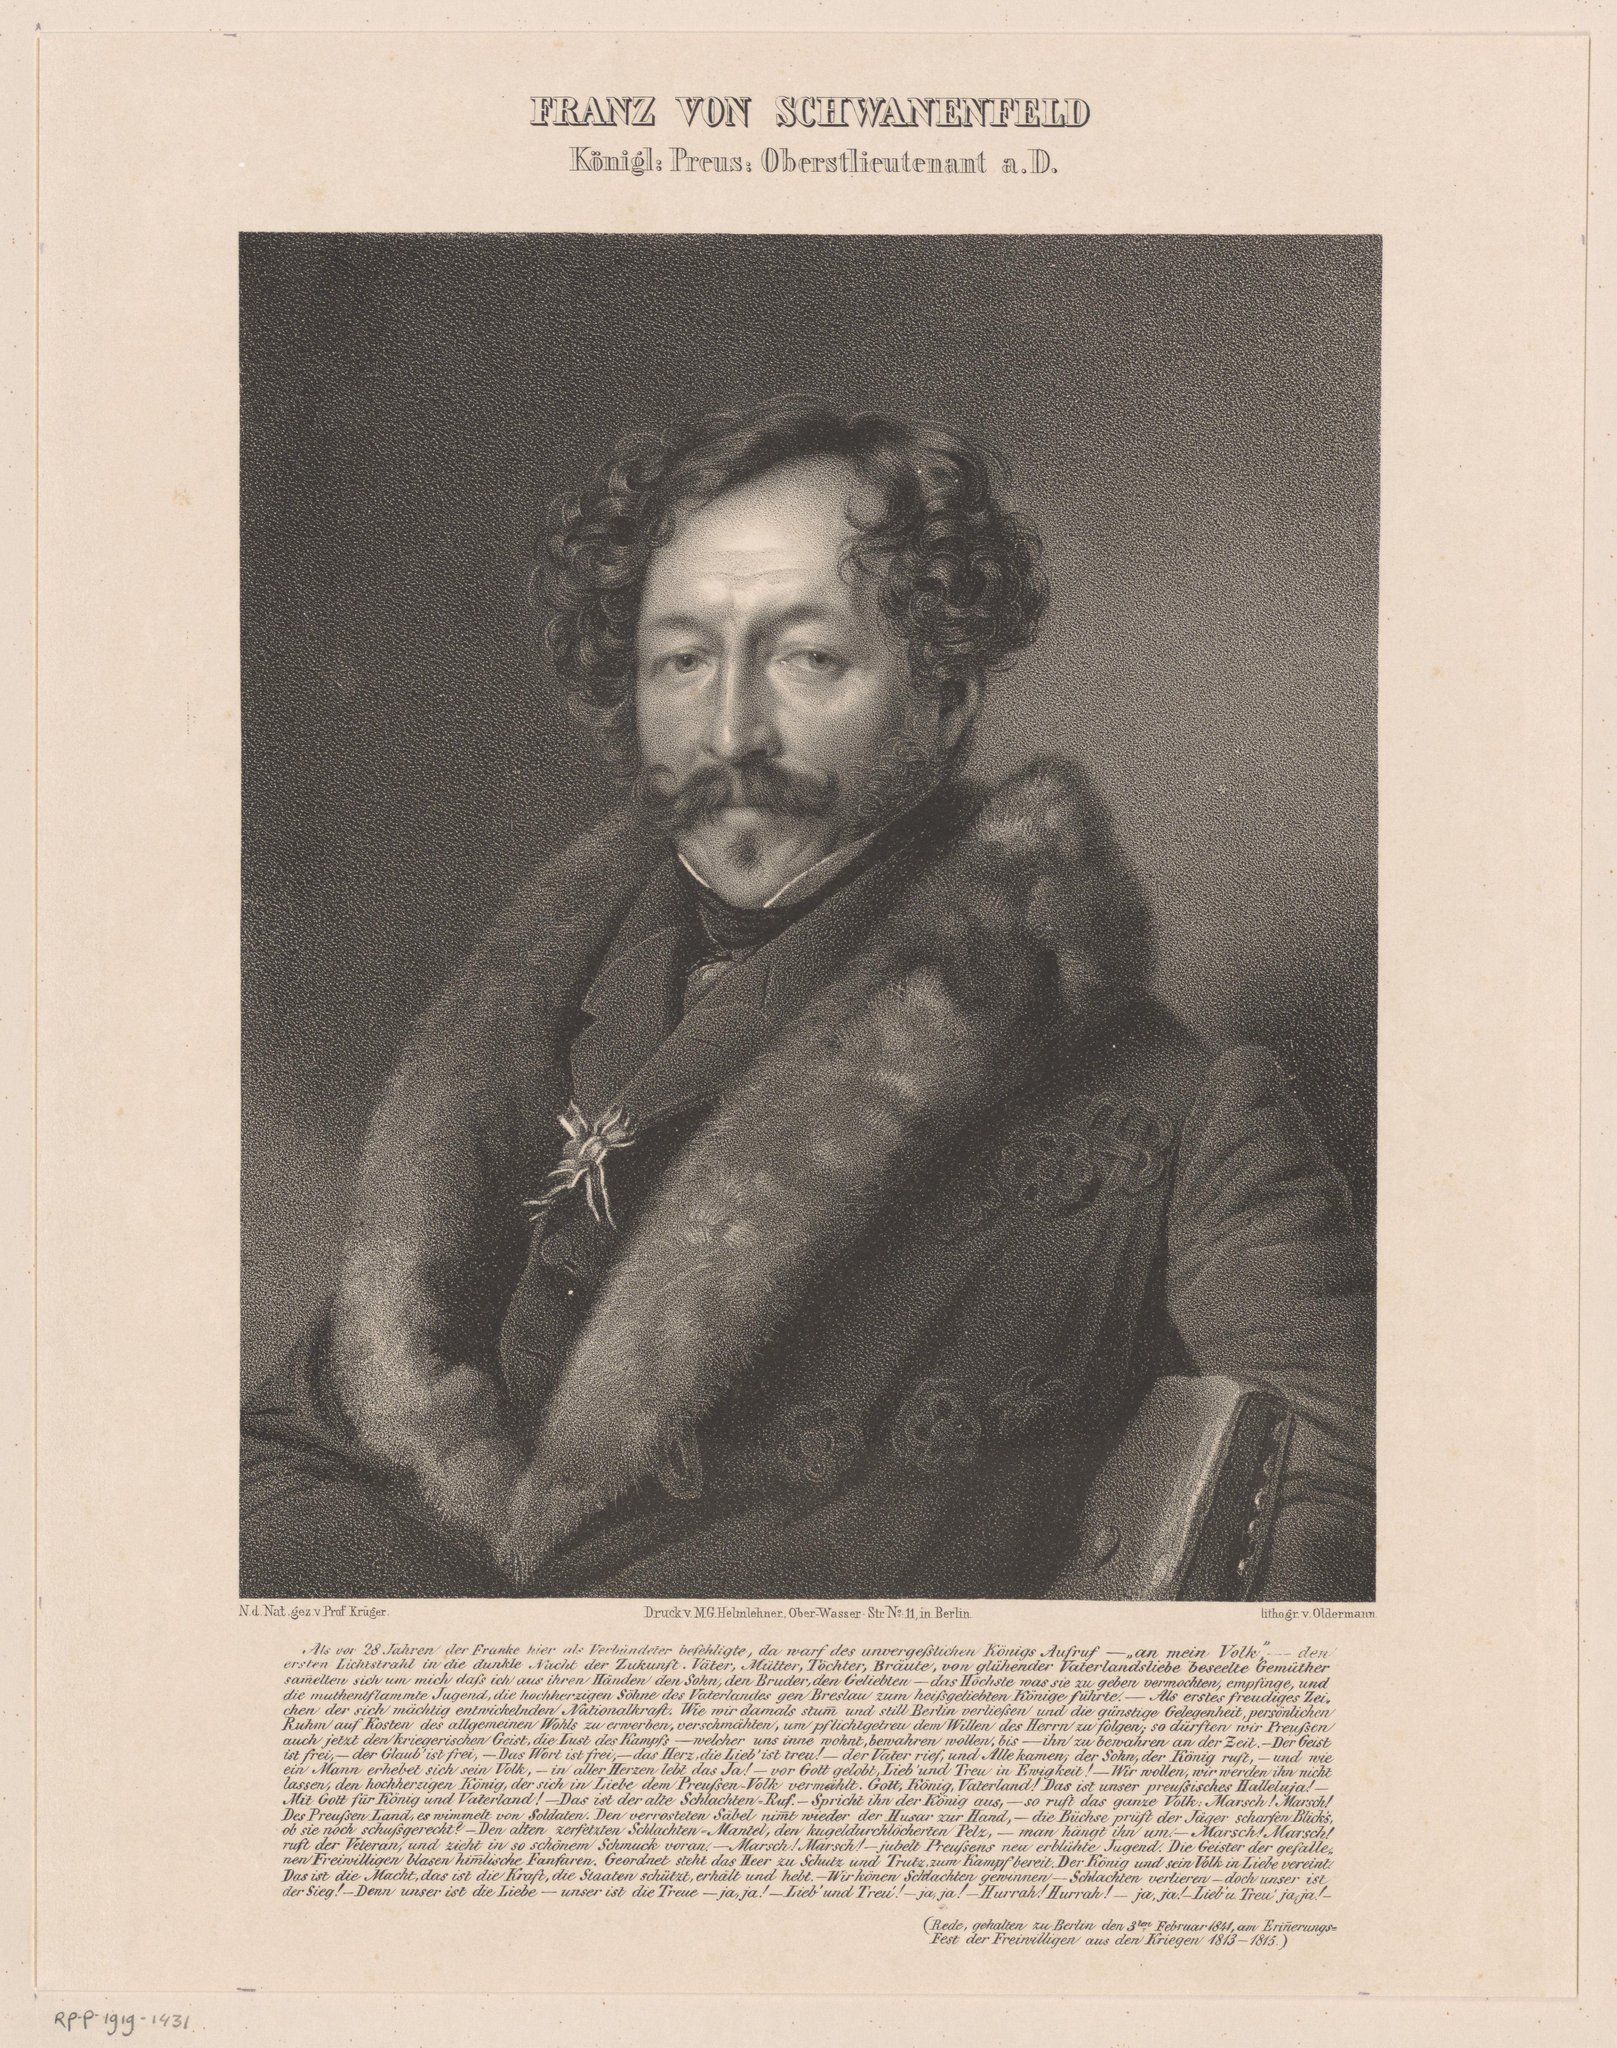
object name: print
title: Franz von Schwanenfeld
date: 1815-1874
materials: paper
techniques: lithograph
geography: berlin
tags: franz von schwanenfeld, moustache, adult man, historical persons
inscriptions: collector's mark: Lugt 2228